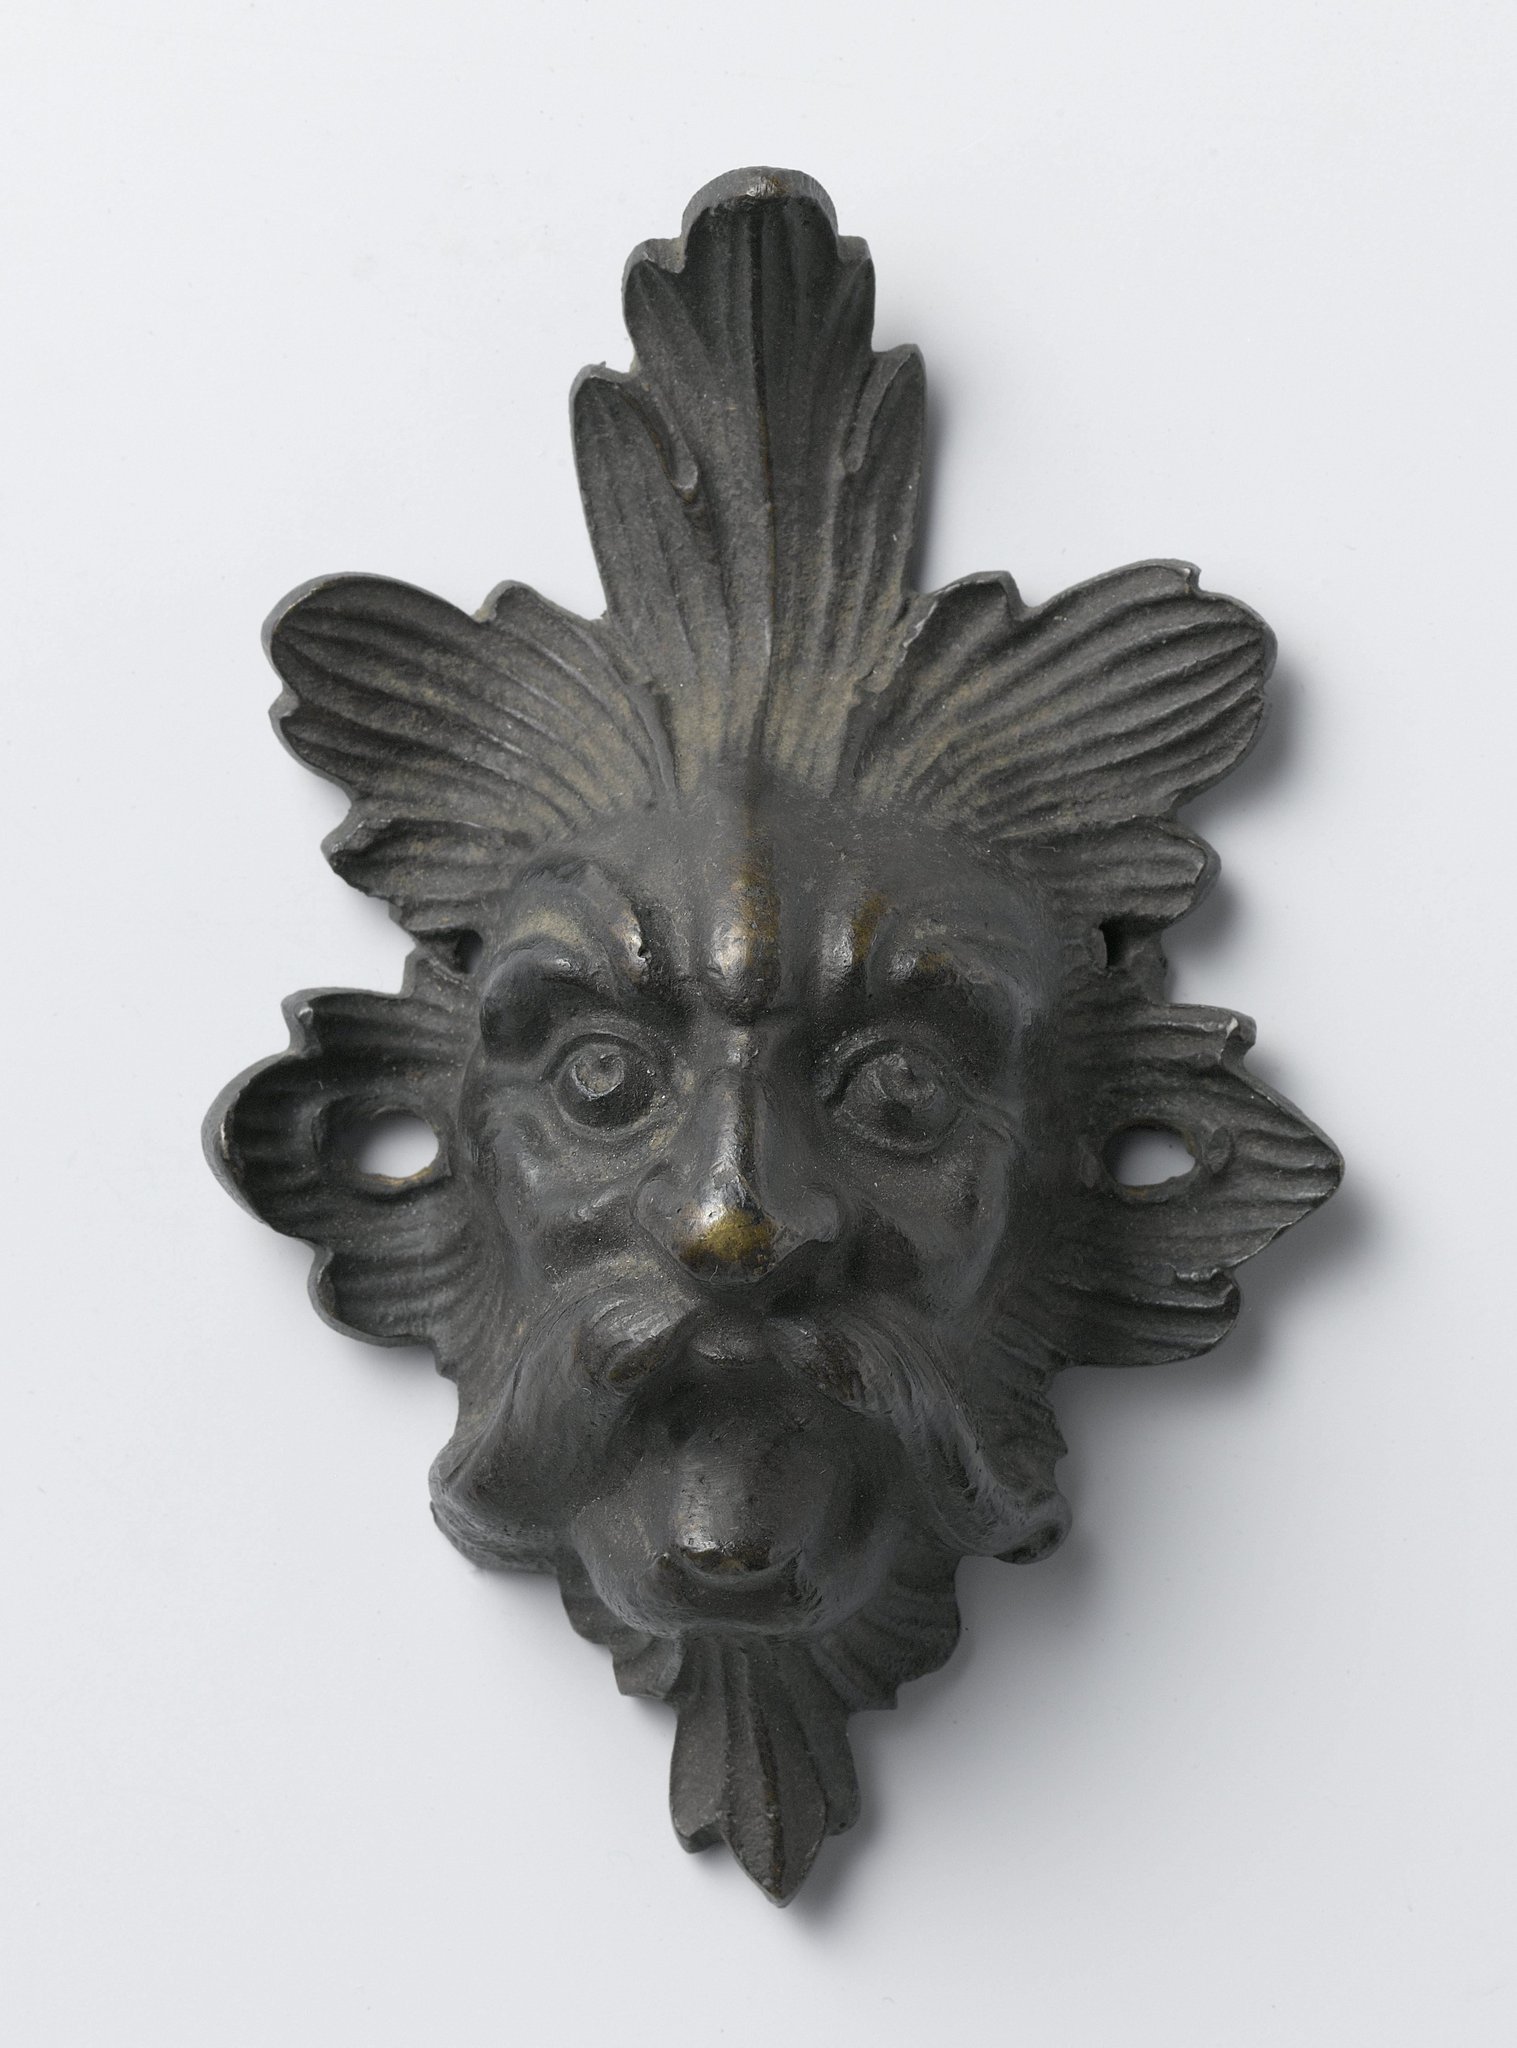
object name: sculpture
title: Mascaron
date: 1600-1699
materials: bronze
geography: italy